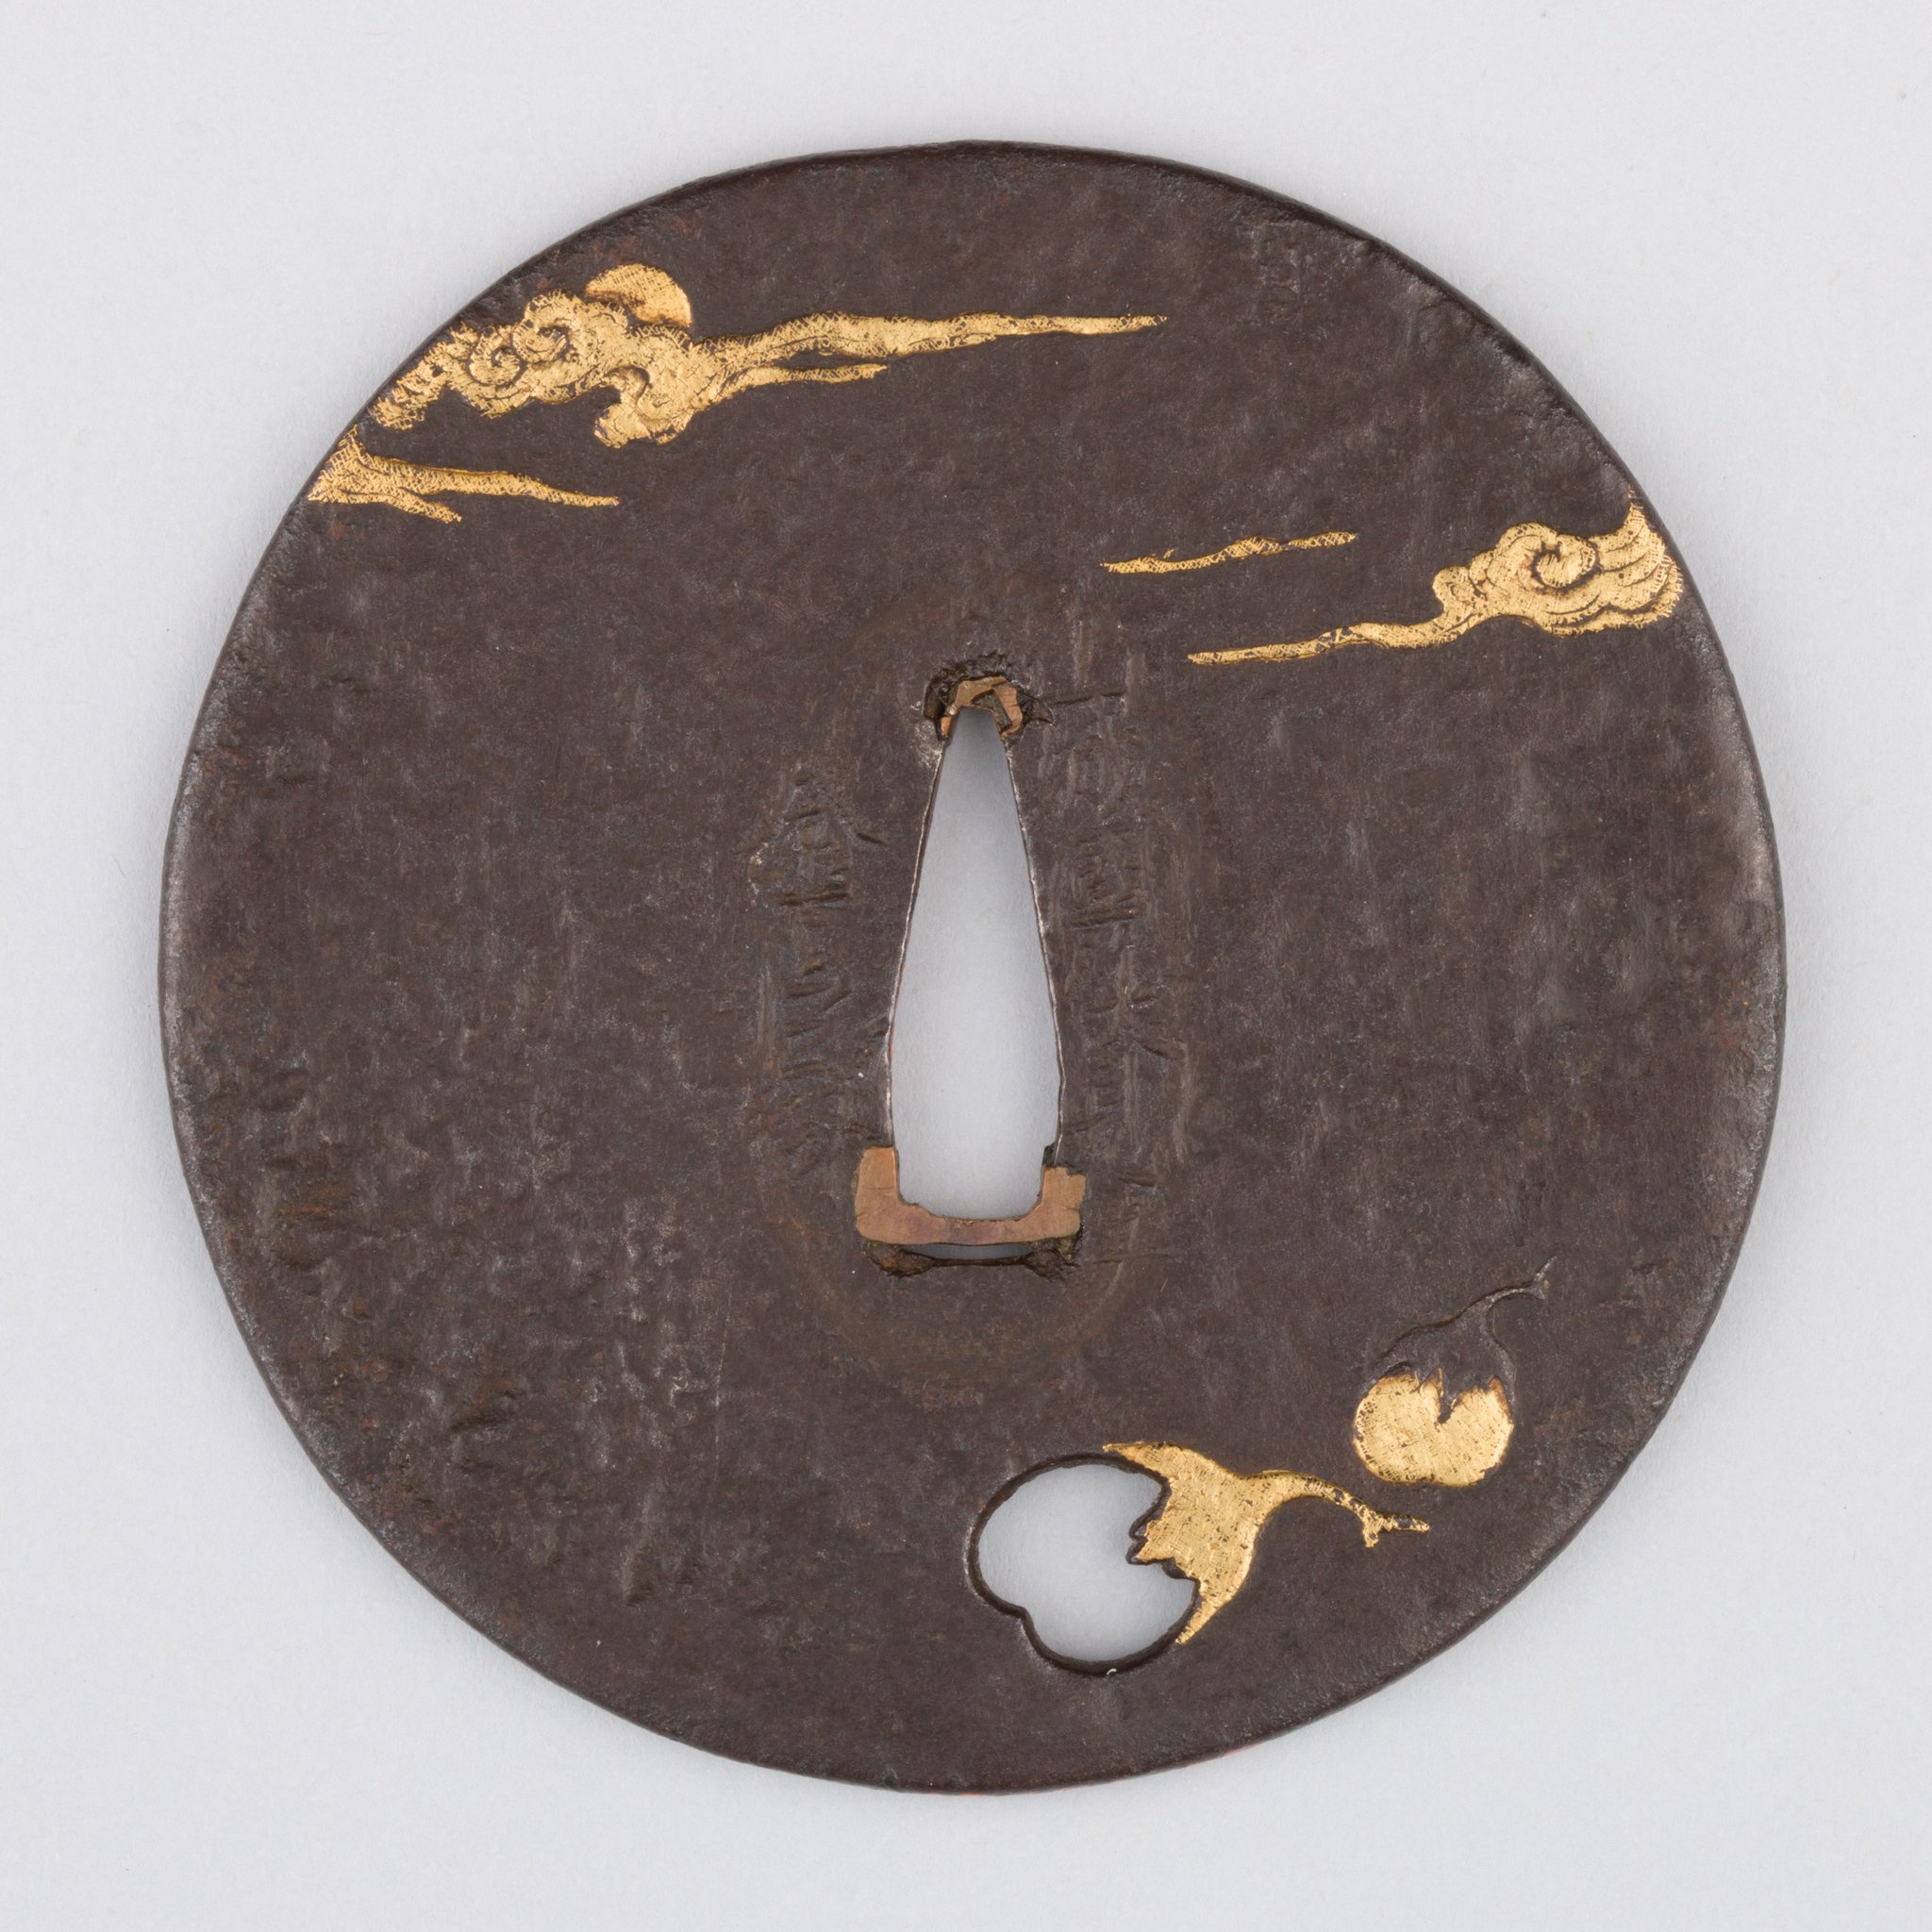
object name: sword guard tsuba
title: Sword Guard (Tsuba)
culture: japanese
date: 1615-1868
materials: copper, gold, iron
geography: japan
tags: vegetables,clouds